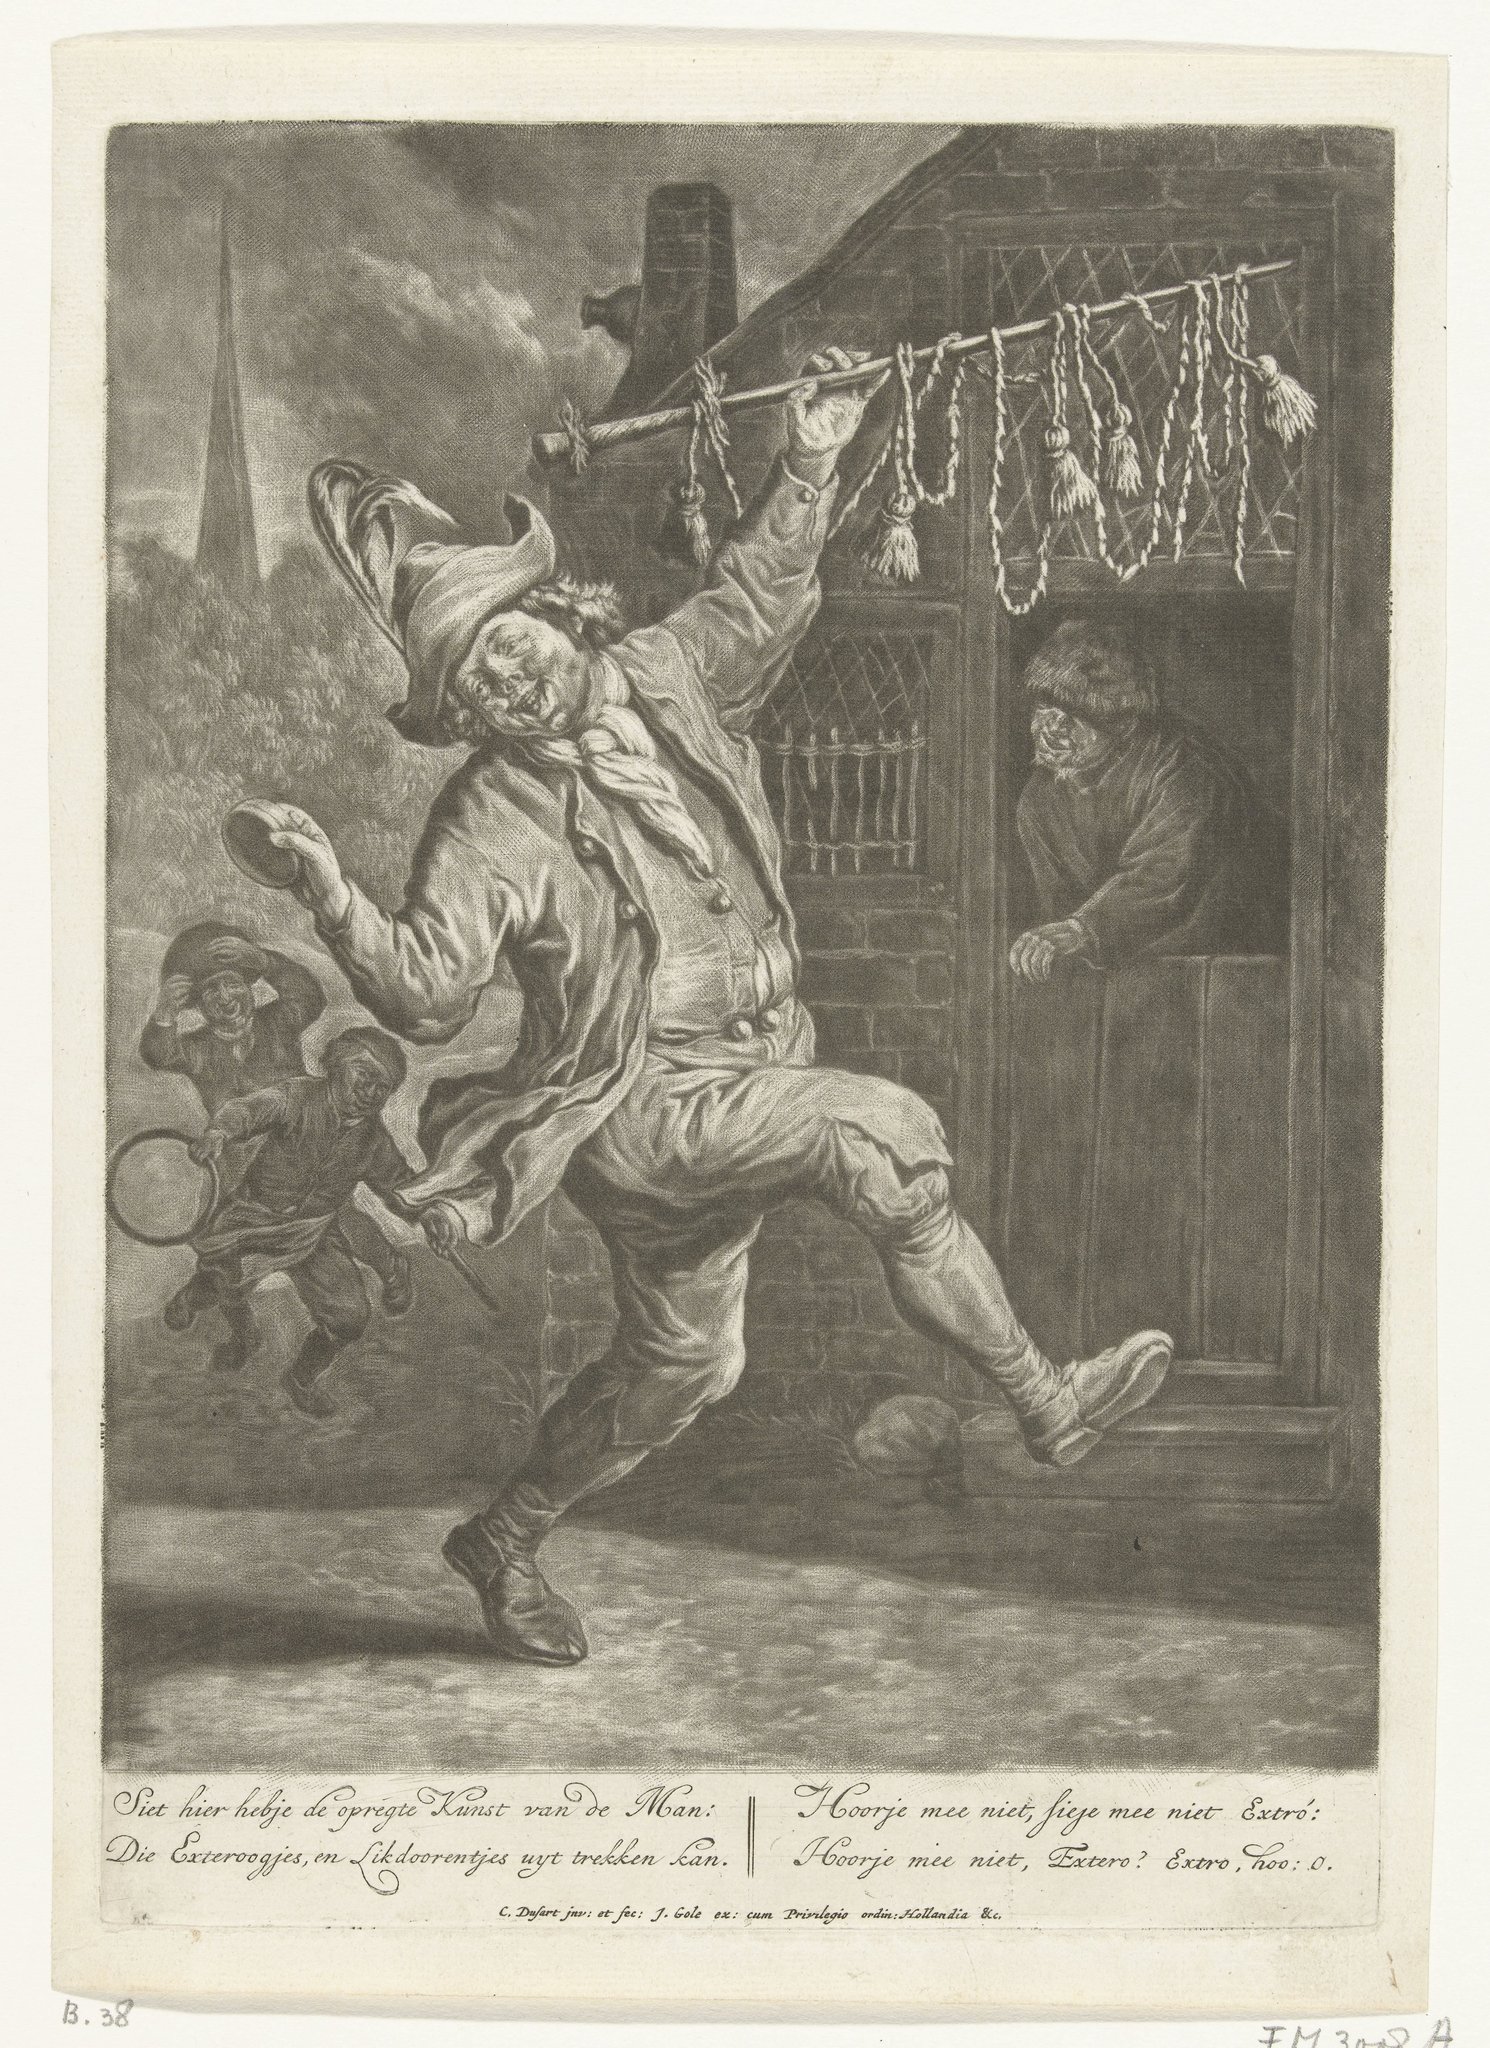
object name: print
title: De likdoornsnijder, ca. 1700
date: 1690-1700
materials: paper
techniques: mezzotint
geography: northern netherlands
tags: unprofessional or illegal practice, popular medicine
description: De likdoornsnijder. Een dansende en zingende man met een tamboerstok behangen met kwasten, in een huisje kijkt over een onderdeur een man lachend toe. In het onderschrift het vierregelig liedje dat de man zingt.